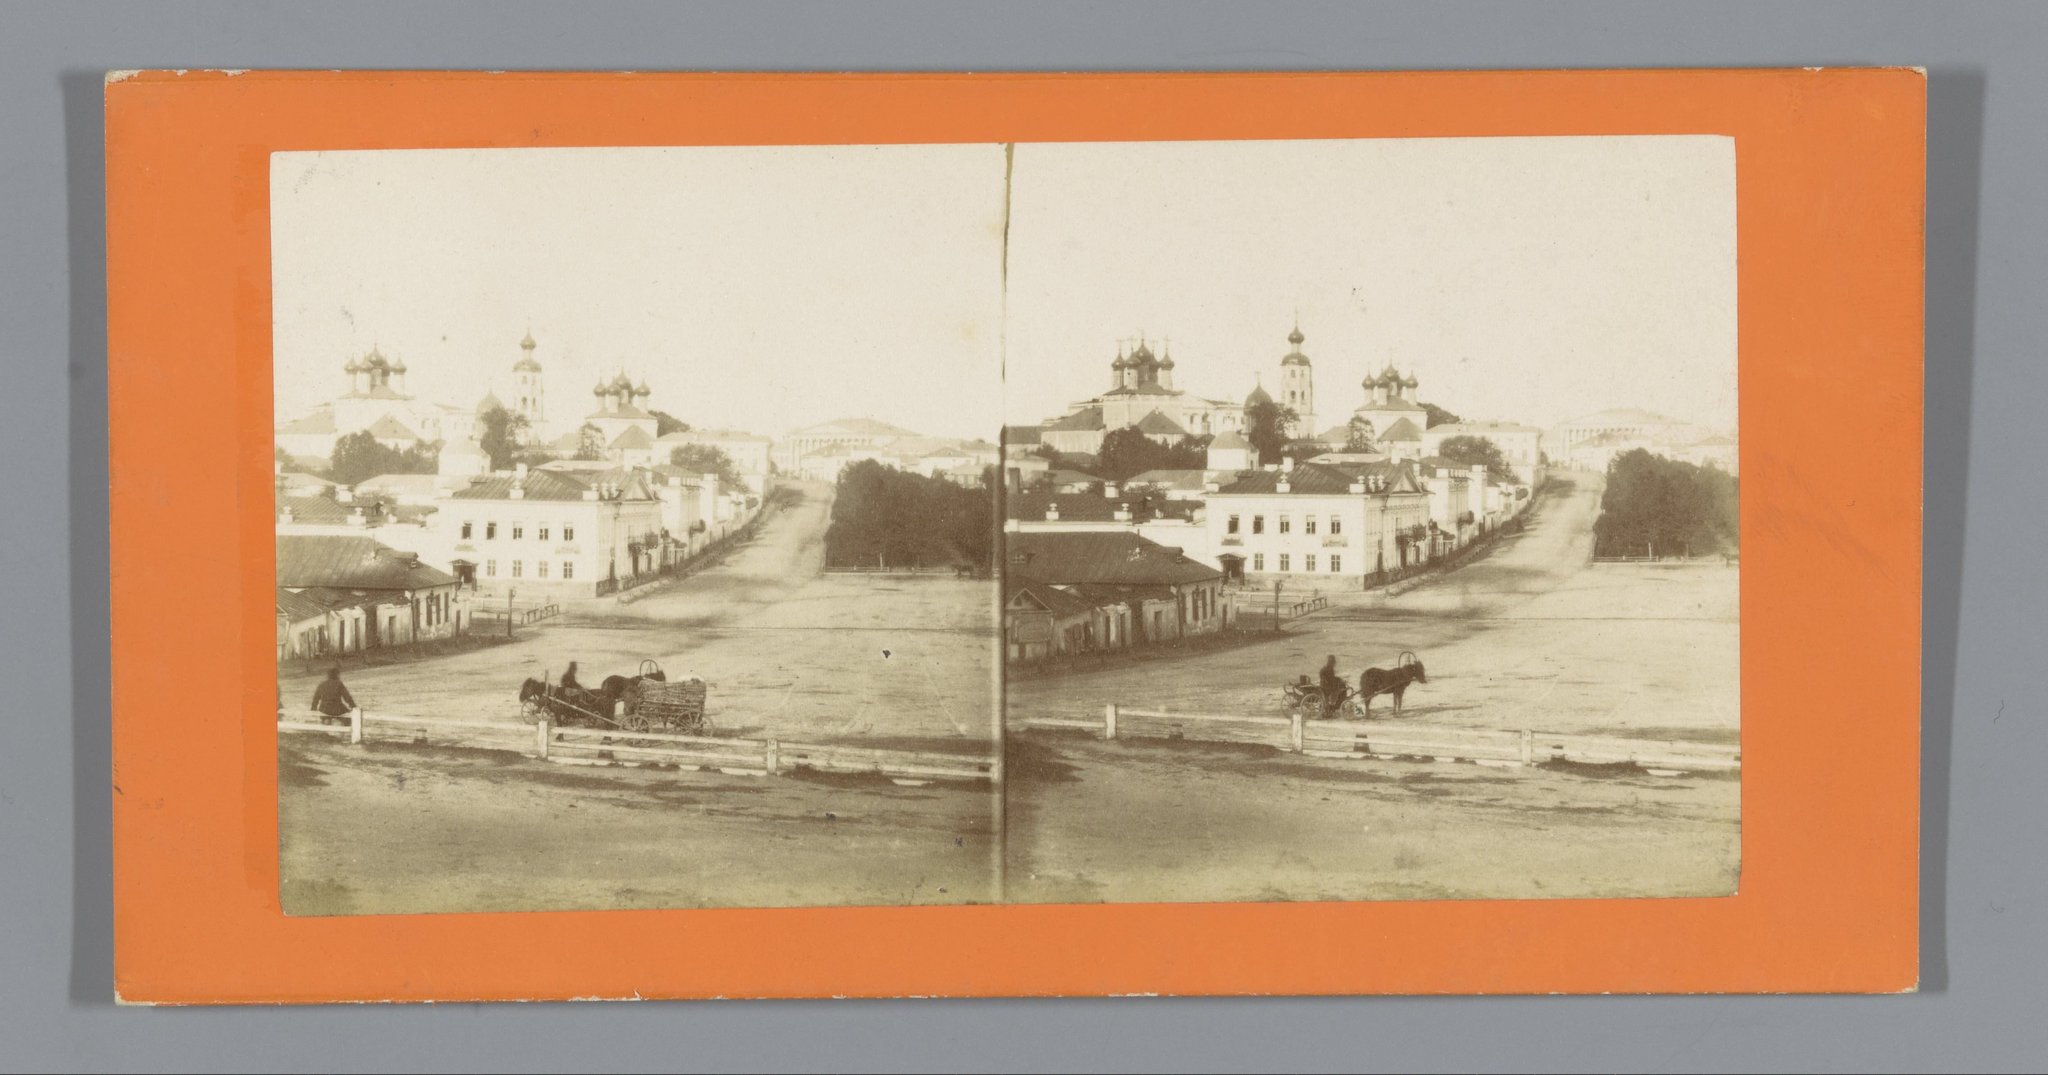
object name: stereograph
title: Gezicht op Moskou, met op de voorgrond personen met paardenkarren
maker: Anonymous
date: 1850-1880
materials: cardboard, photographic support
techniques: albumen print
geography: moscow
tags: city-view, and landscape with man-made constructions, four-wheeled, animal-drawn vehicle, e.g.: cab, carriage, coach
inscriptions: inscription: ‘64 Panorama de Moscou pris du Boulevard’